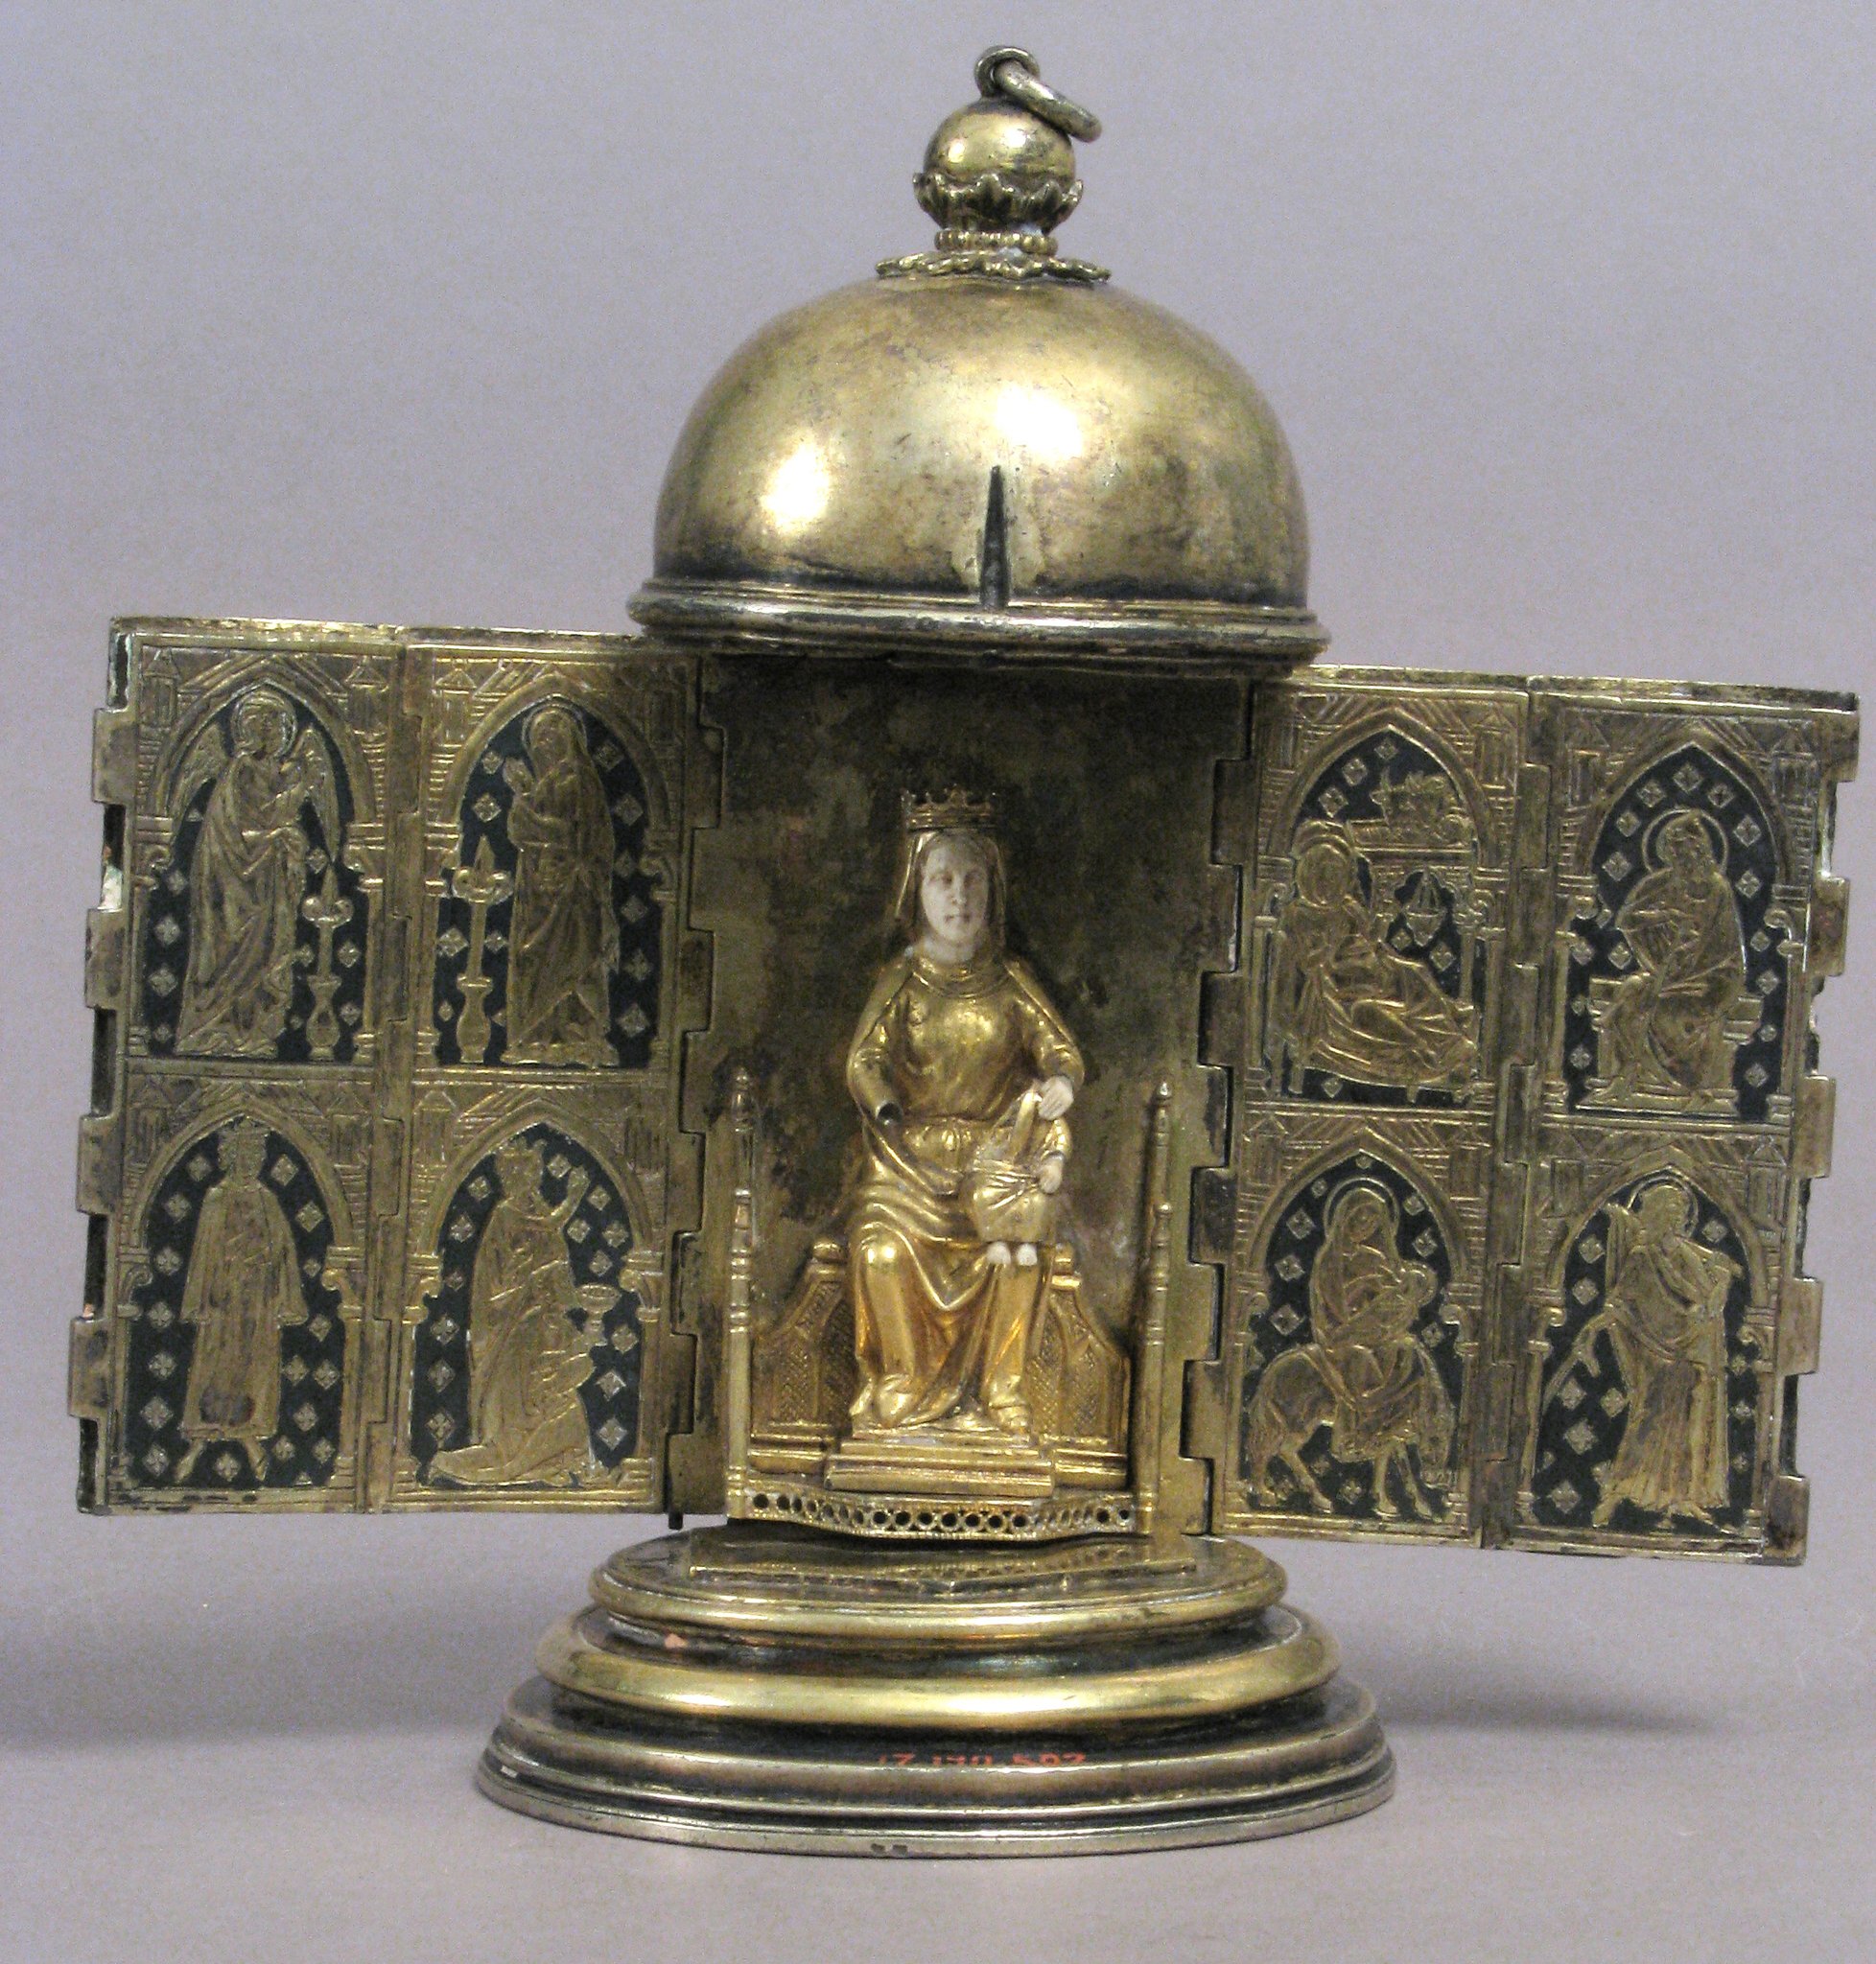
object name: polyptych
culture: franco-netherlandish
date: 1801-1900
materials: gold, ivory, niello, silver gilt